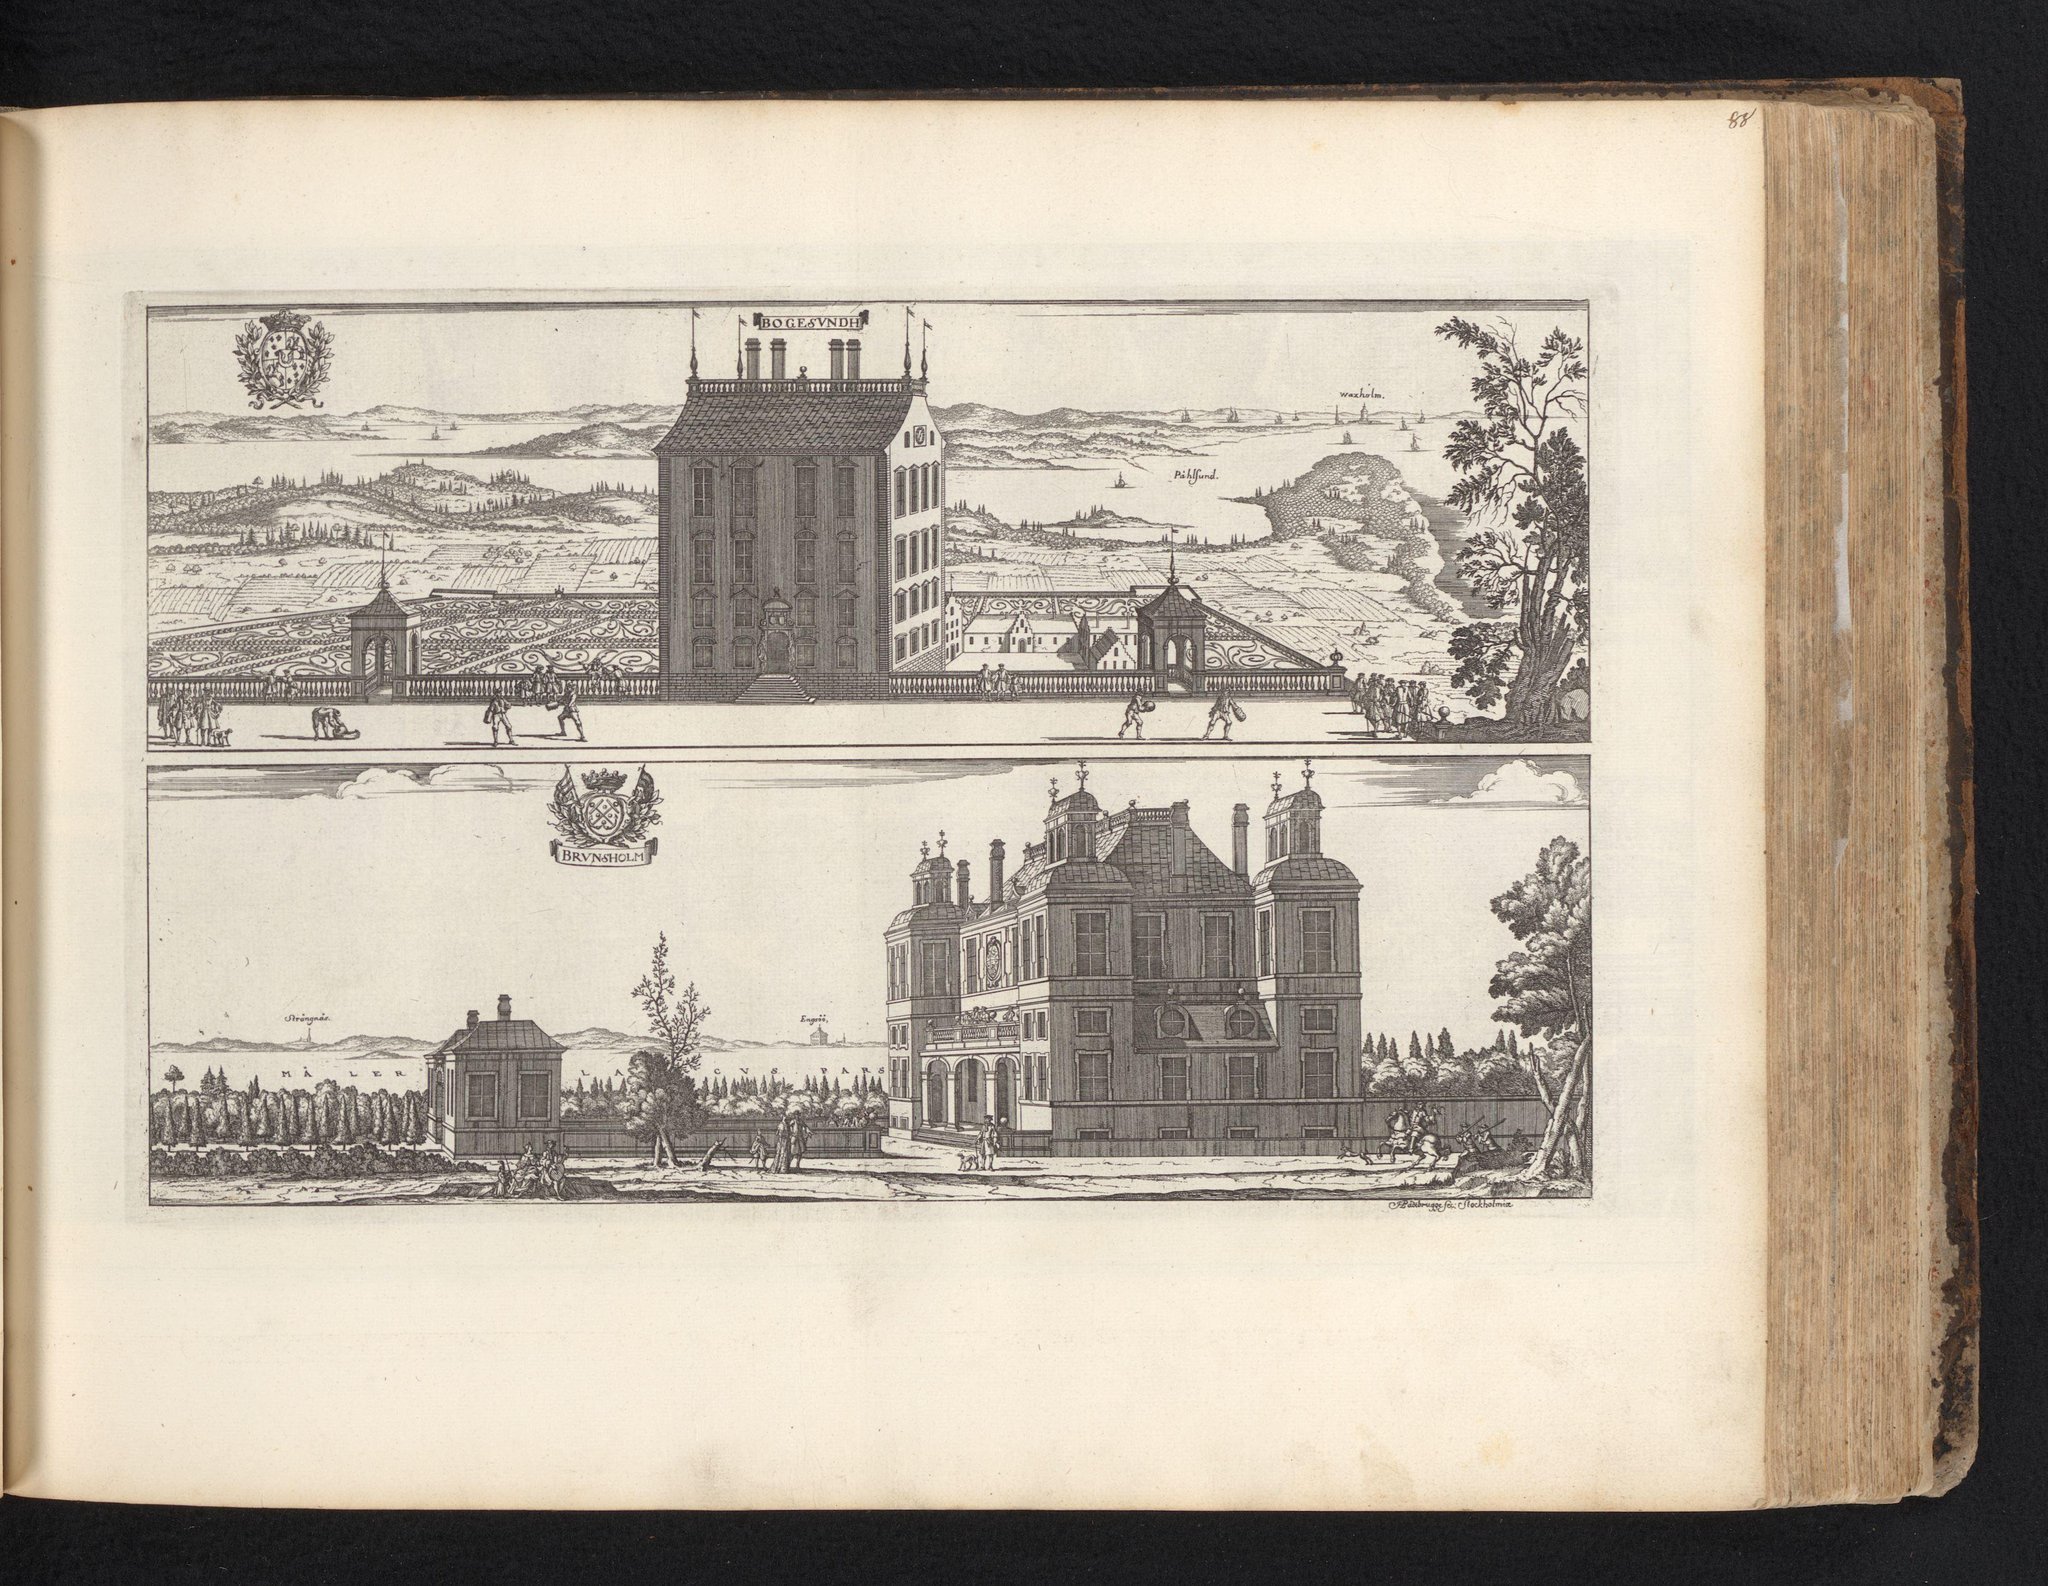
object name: album leaf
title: Suecia Antiqua et Hodierna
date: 1686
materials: paper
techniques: etching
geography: stockholm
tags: landgoed brunnsholm, slot bogesund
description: Kungliga Biblioteket, 'Suecia': http://www.kb.se/samlingarna/Kartor-bilder/Suecia-antiqua/ (geraadpleegd november 2016).